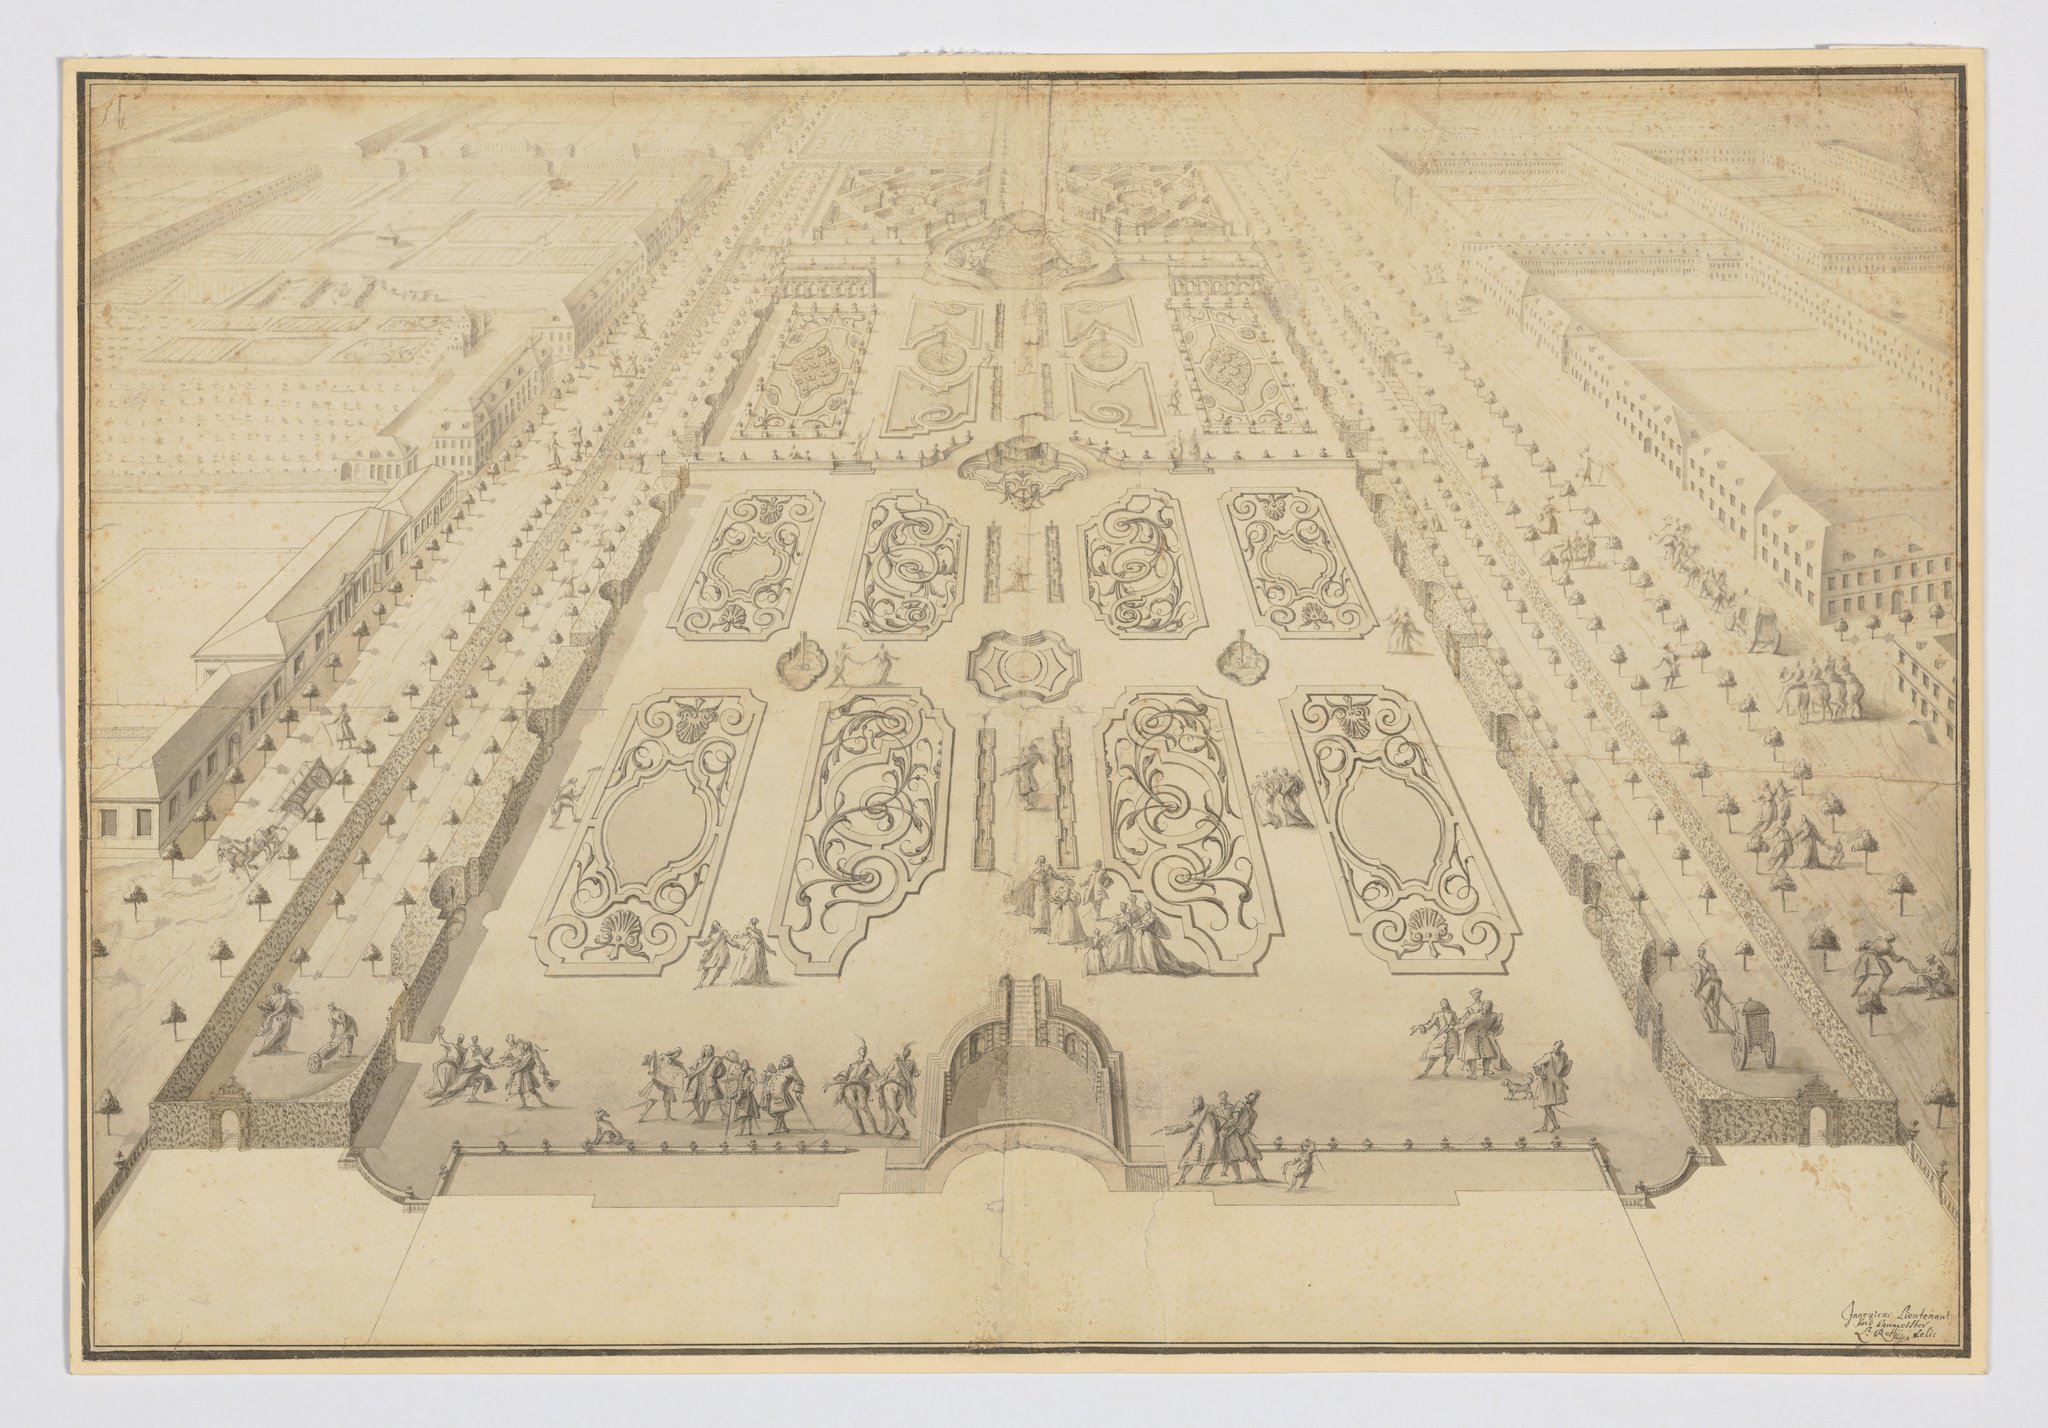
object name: drawing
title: Bird's-Eye View of Part of the Gardens at Ludwigsburg, created for Duke Eberhard Ludwig von Württemburg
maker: anonymous, german, 18th century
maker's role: artist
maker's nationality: german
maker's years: 1700-1800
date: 1701-1800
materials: graphite, ink, watercolor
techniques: pen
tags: gardens